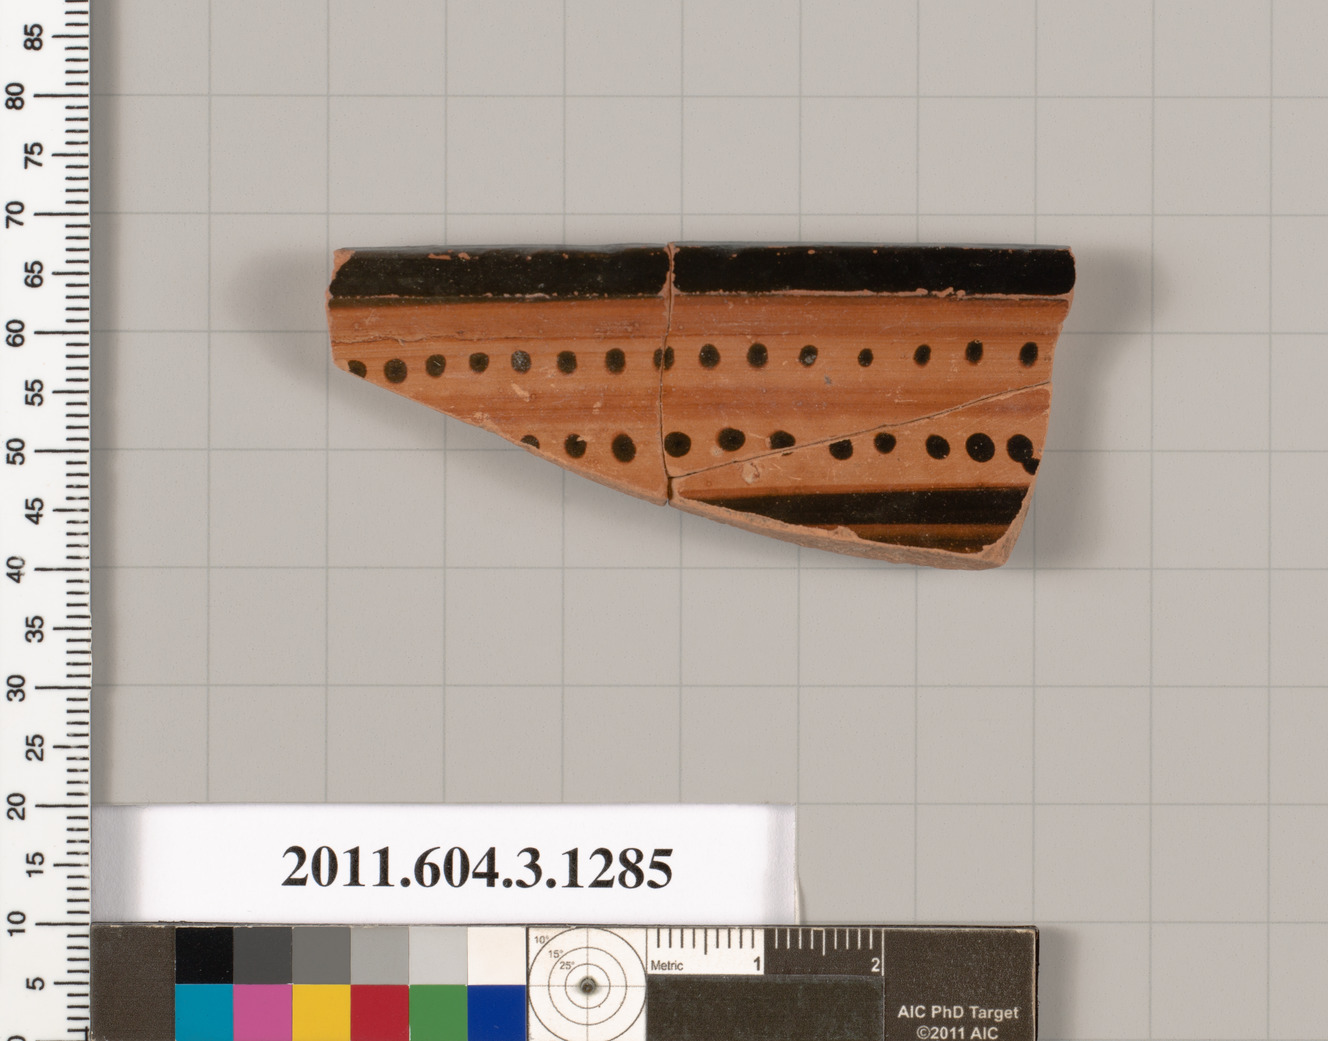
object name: skyphos fragment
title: Terracotta rim fragment of a skyphos (deep drinking cup)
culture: greek, attic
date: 500 BCE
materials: terracotta